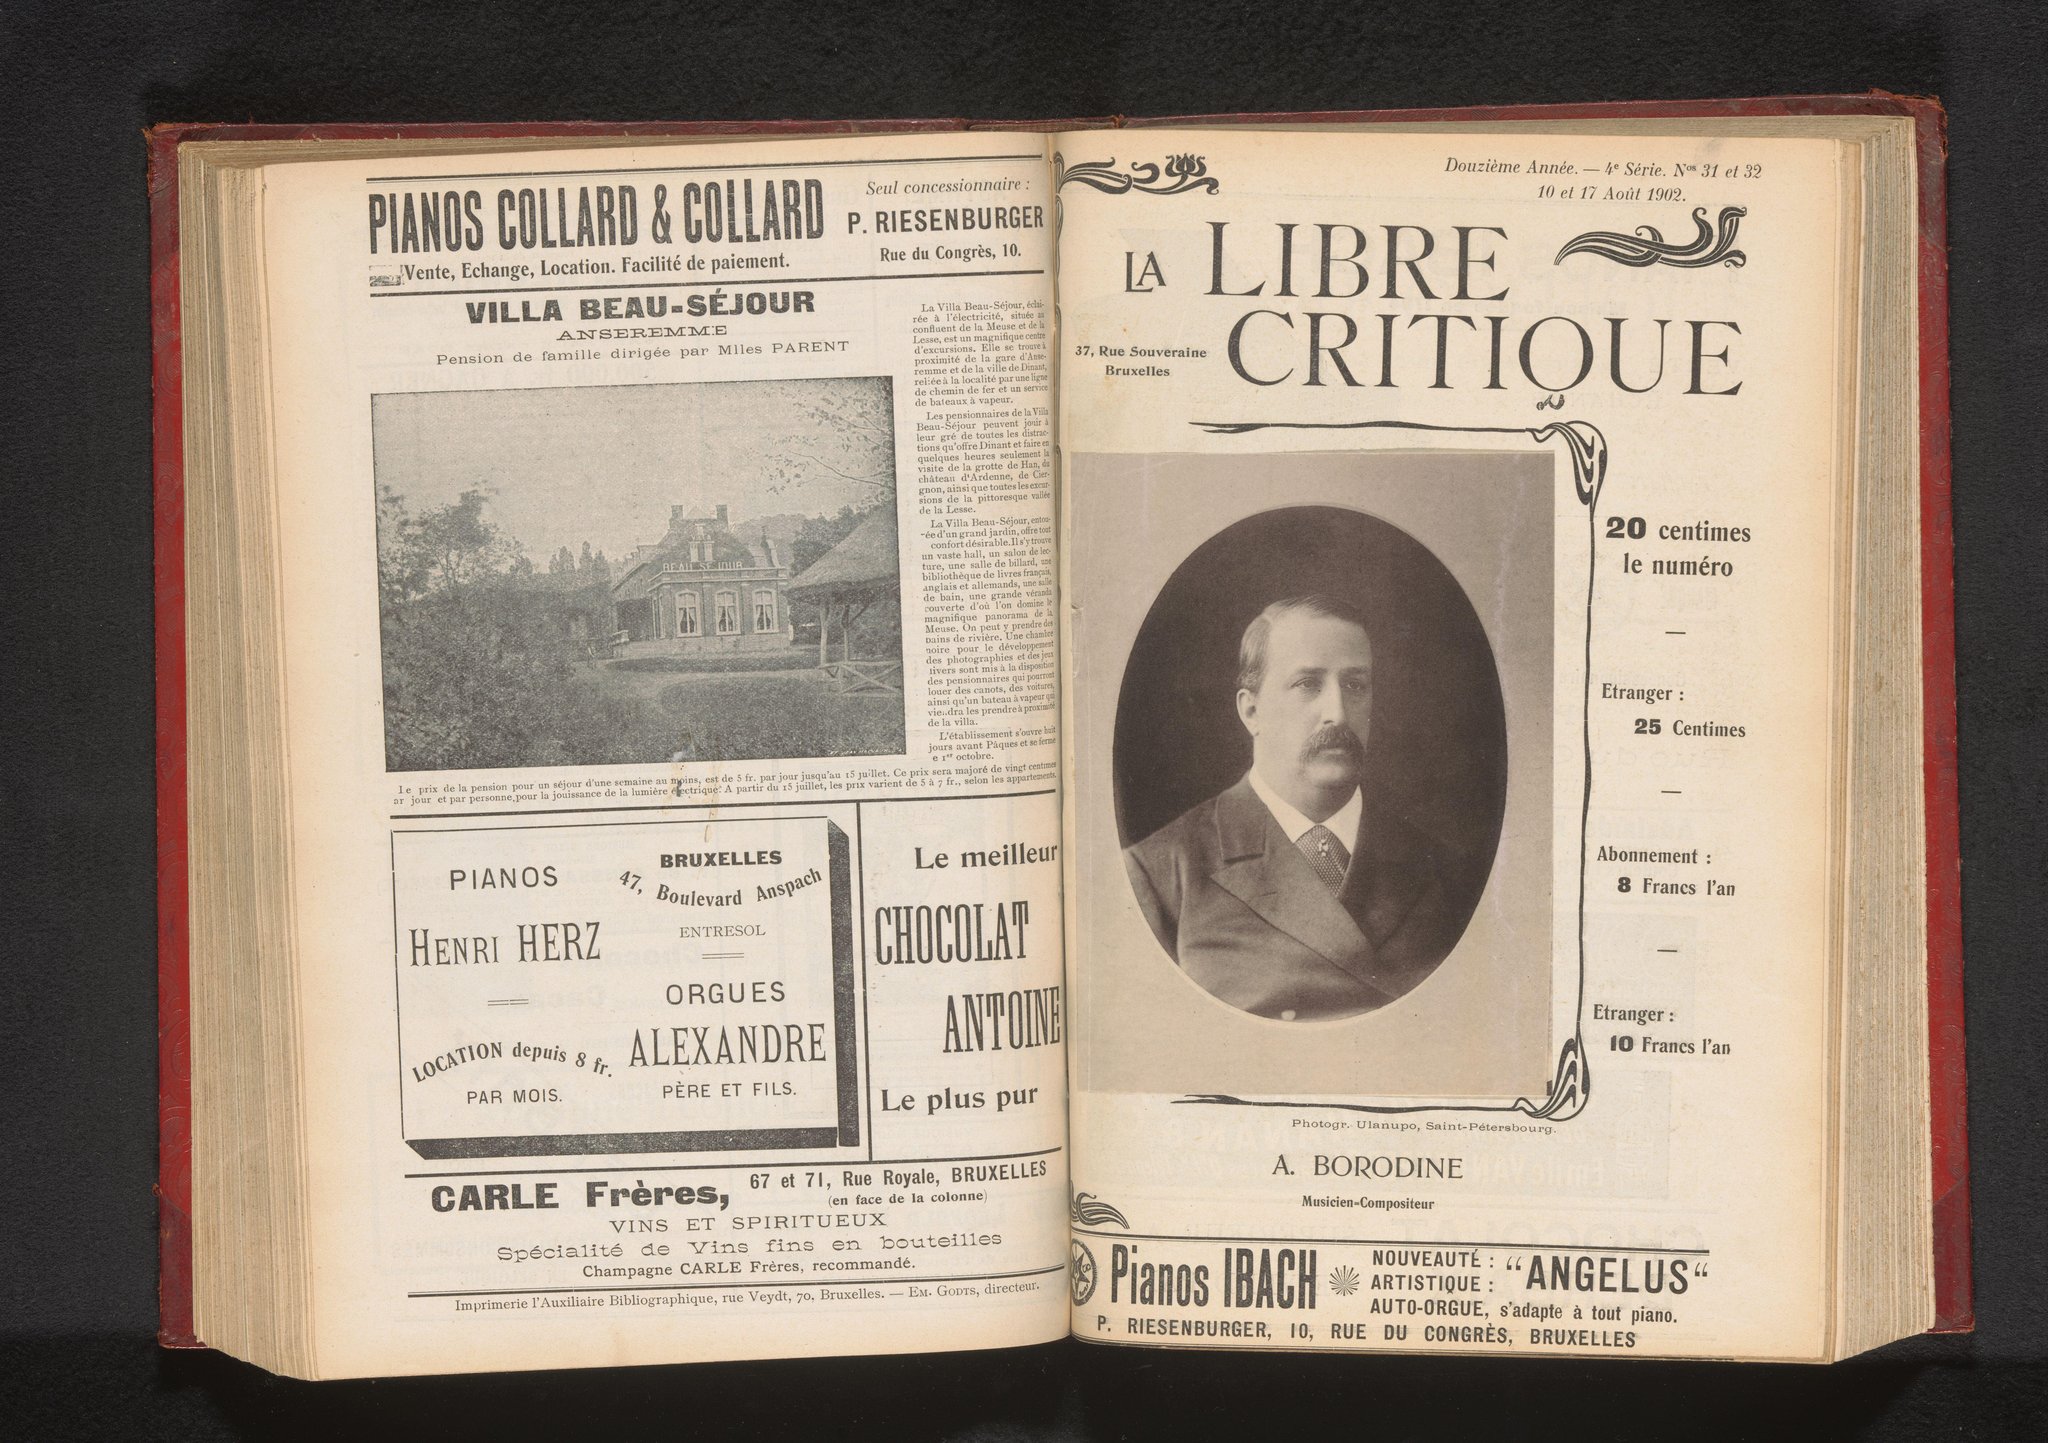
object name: photomechanical print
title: A. Borodine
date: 1897-1902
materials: paper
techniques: photograph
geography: sint-petersburg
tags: portrait of composer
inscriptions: inscription: ‘Musicien-Compositeur’